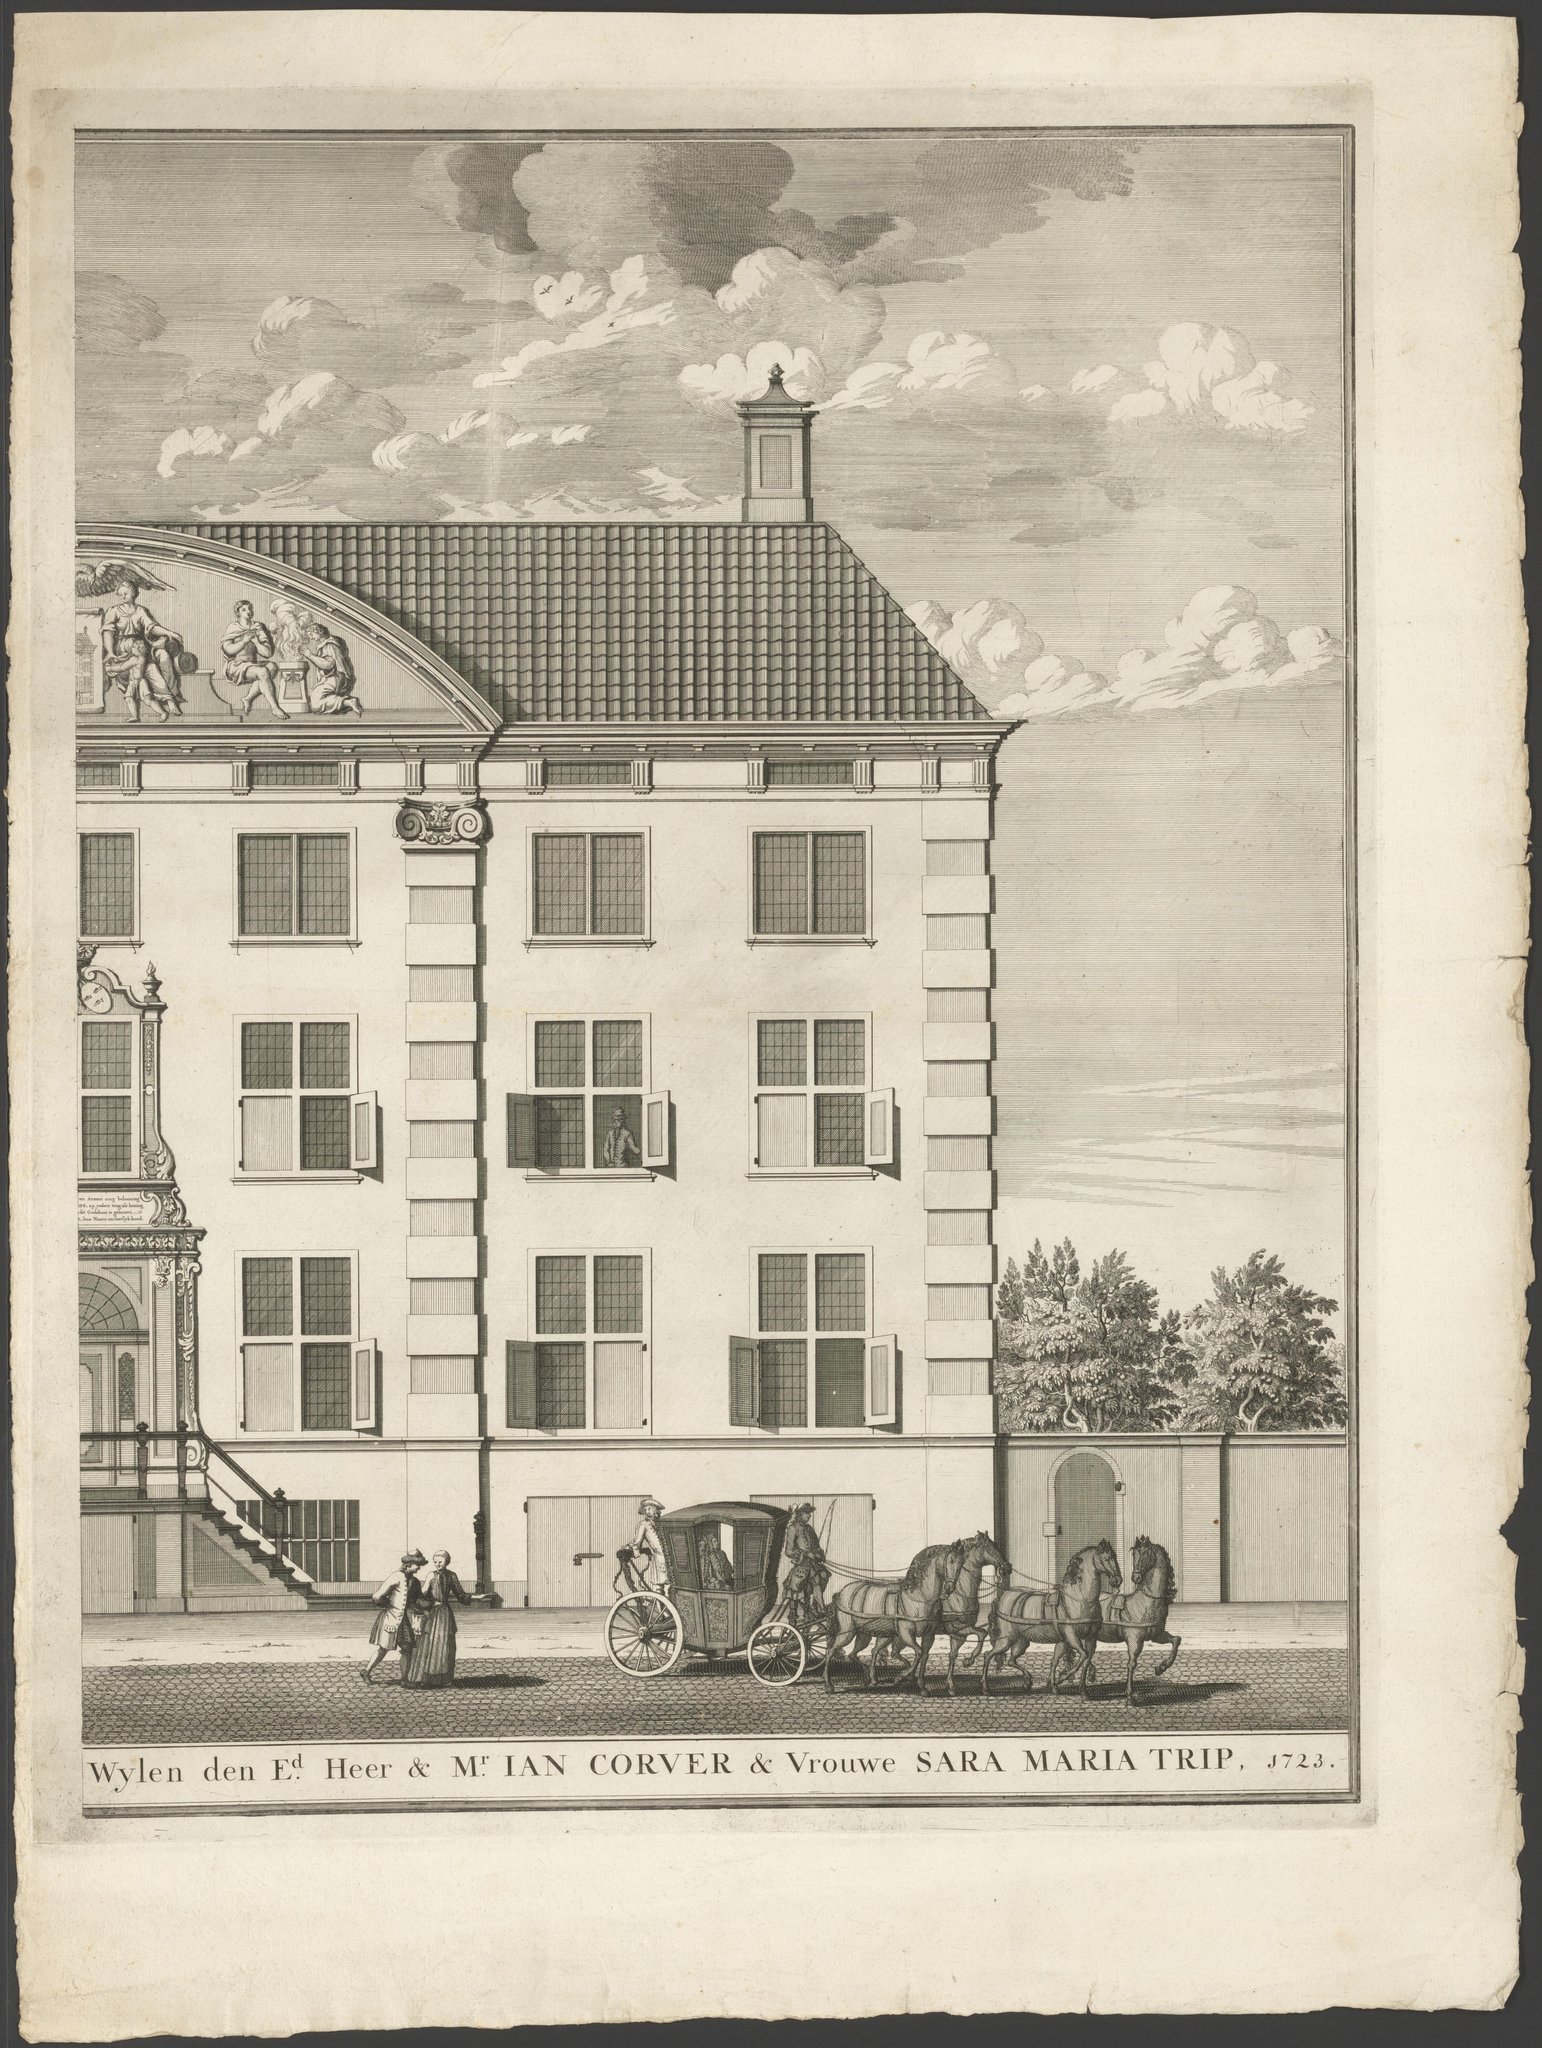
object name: print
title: Gezicht op de voorgevel van het Corvershof te Amsterdam (rechterdeel)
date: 1723-1748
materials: paper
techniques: engraving, etching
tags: alms-house (dutch: 'hofje'), public welfare, old-people's home, street (+ city(-scape) with figures, staffage)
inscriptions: collector's mark: Lugt 1641, collector's mark: ‘ARMWEZEN EN LIEFDADIGHEID’, collector's mark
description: Rechterdeel van een gezicht op de voorgevel van het Corvershof te Amsterdam, bestaande uit twee delen. Onderwerpsrubrieken binnen de Atlas Zeden en Gewoonten: Armwezen en Liefdadigheid.